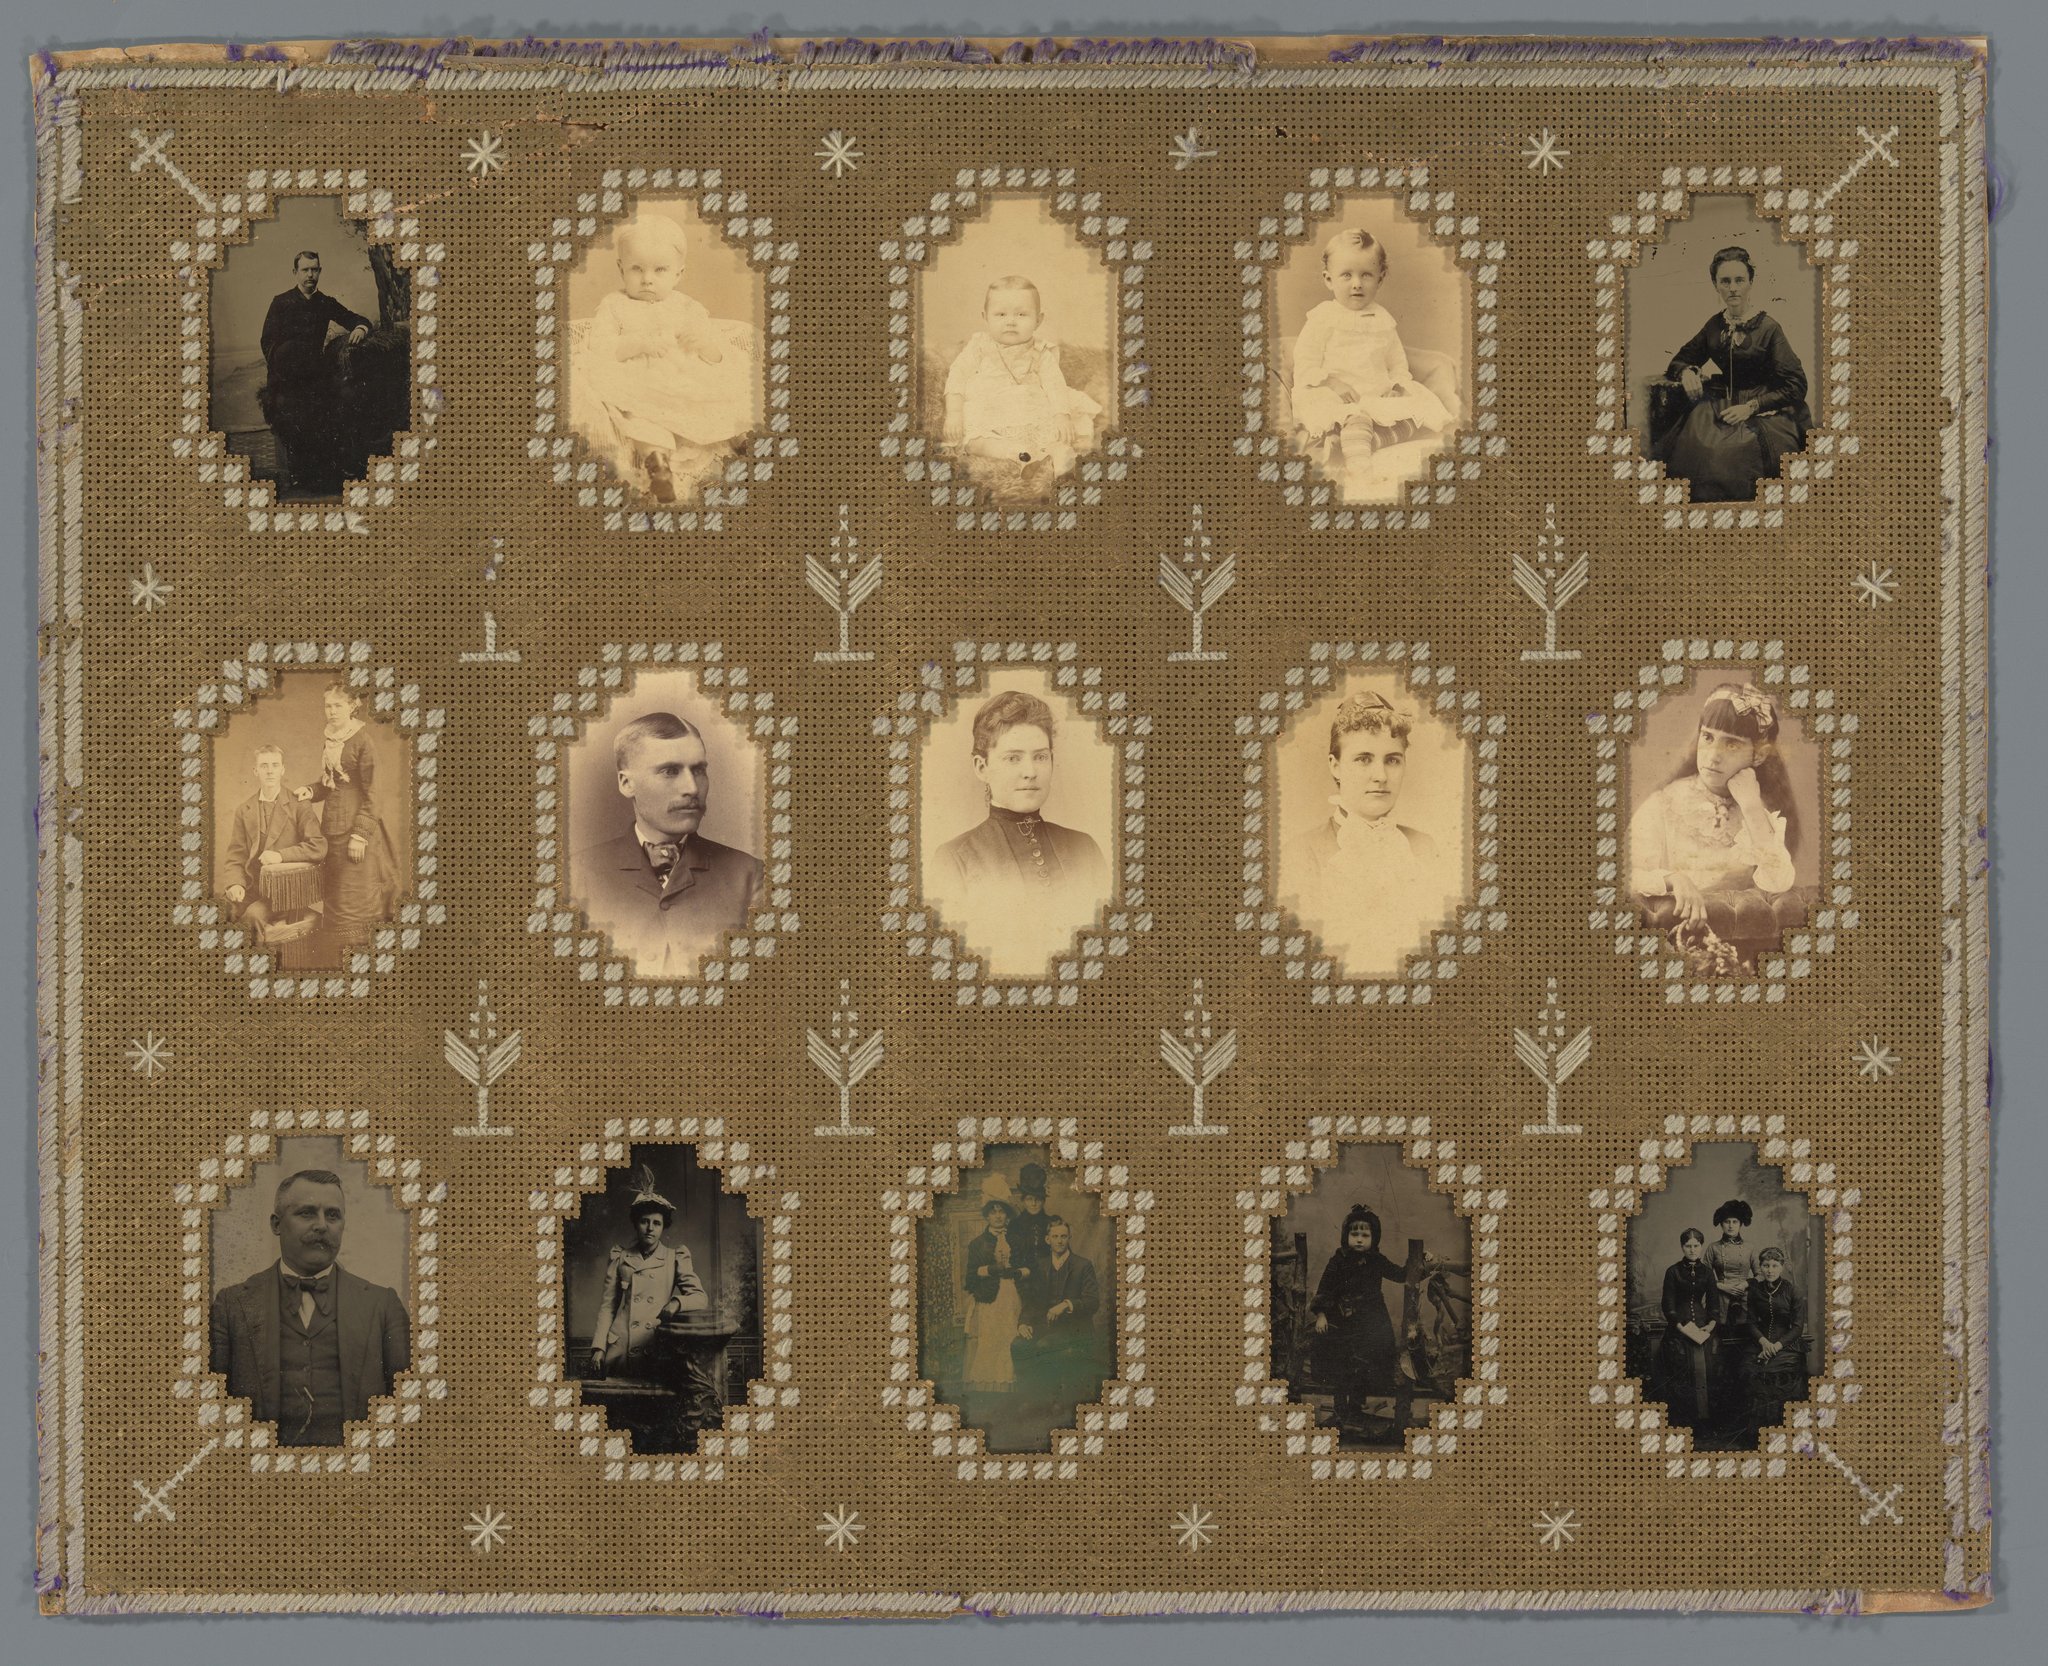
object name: frame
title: Lijst met 15 portretten van onbekende personen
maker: Anonymous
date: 1880-1900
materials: cardboard, wood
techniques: albumen print, ferrotyping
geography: united states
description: Zeven ferrotypieën en 8 albuminedrukken in passepartout met borduurwerk